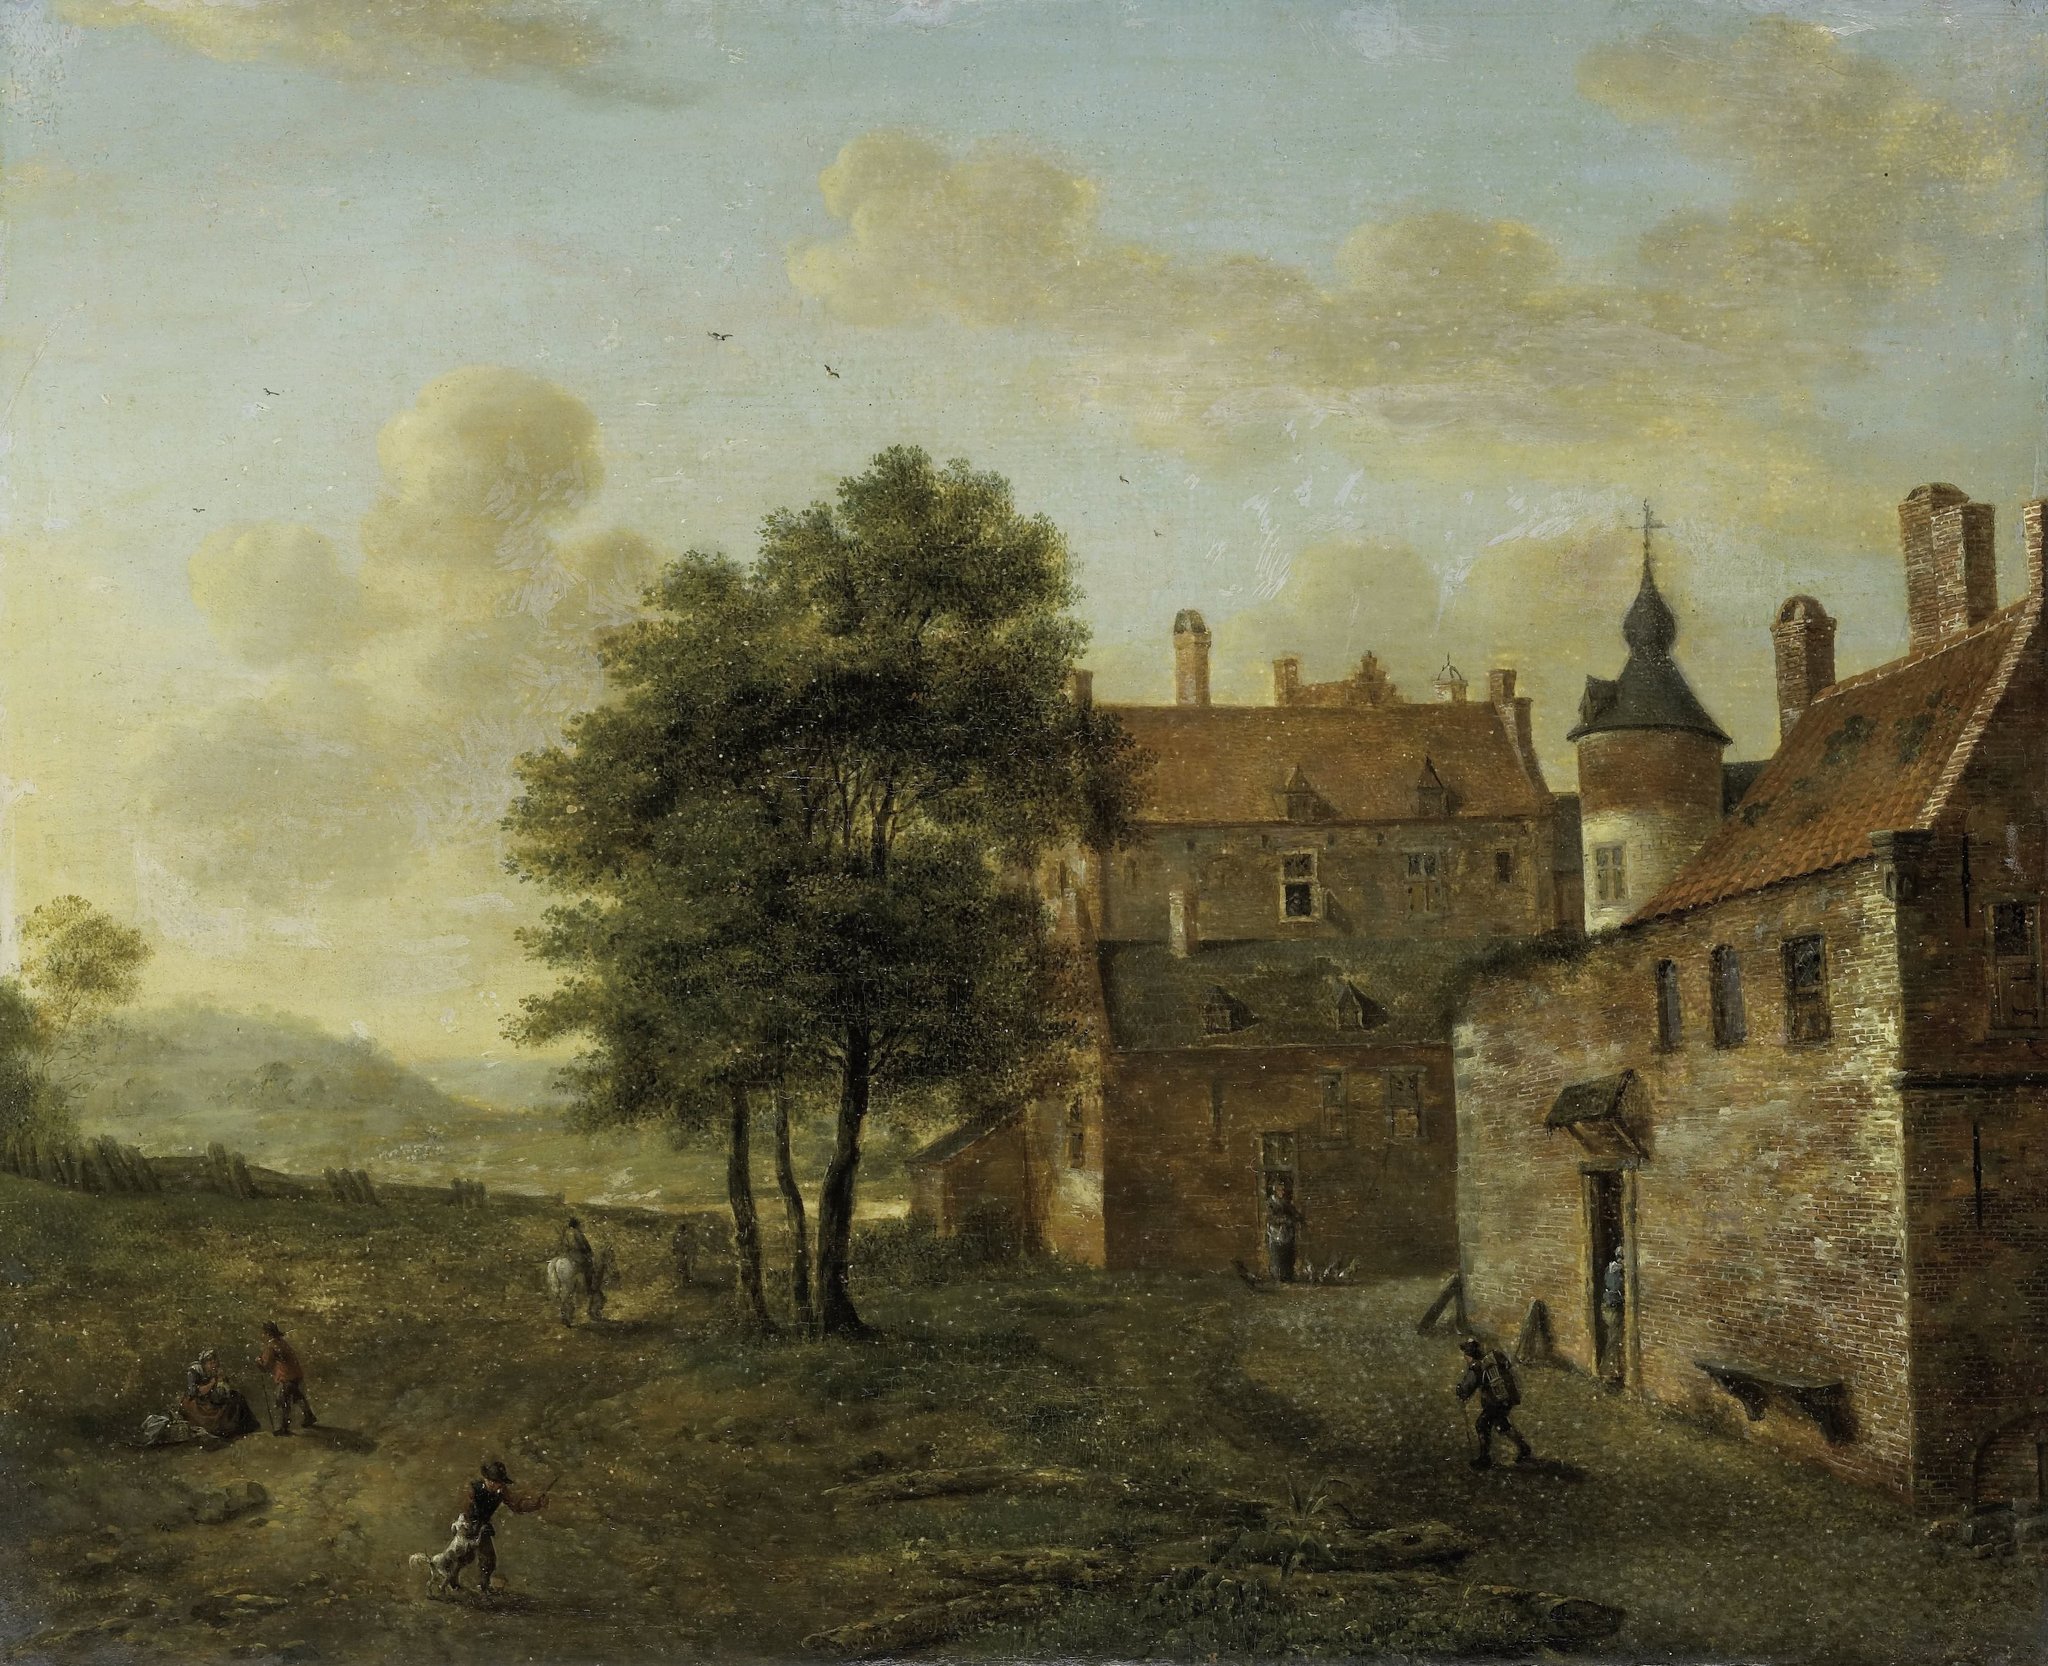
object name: painting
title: A Country Home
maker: jan van der heyden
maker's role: draughtsman, painter, print maker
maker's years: 1637-1712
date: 1660-1712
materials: oil, panel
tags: country-house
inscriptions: signature: ‘J. v.d. Heyden f.’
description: Een landhuis gelegen langs een weg met verschillende figuren. Voor de deur van achterste deel van het huis staat een vrouw die kippen voert.